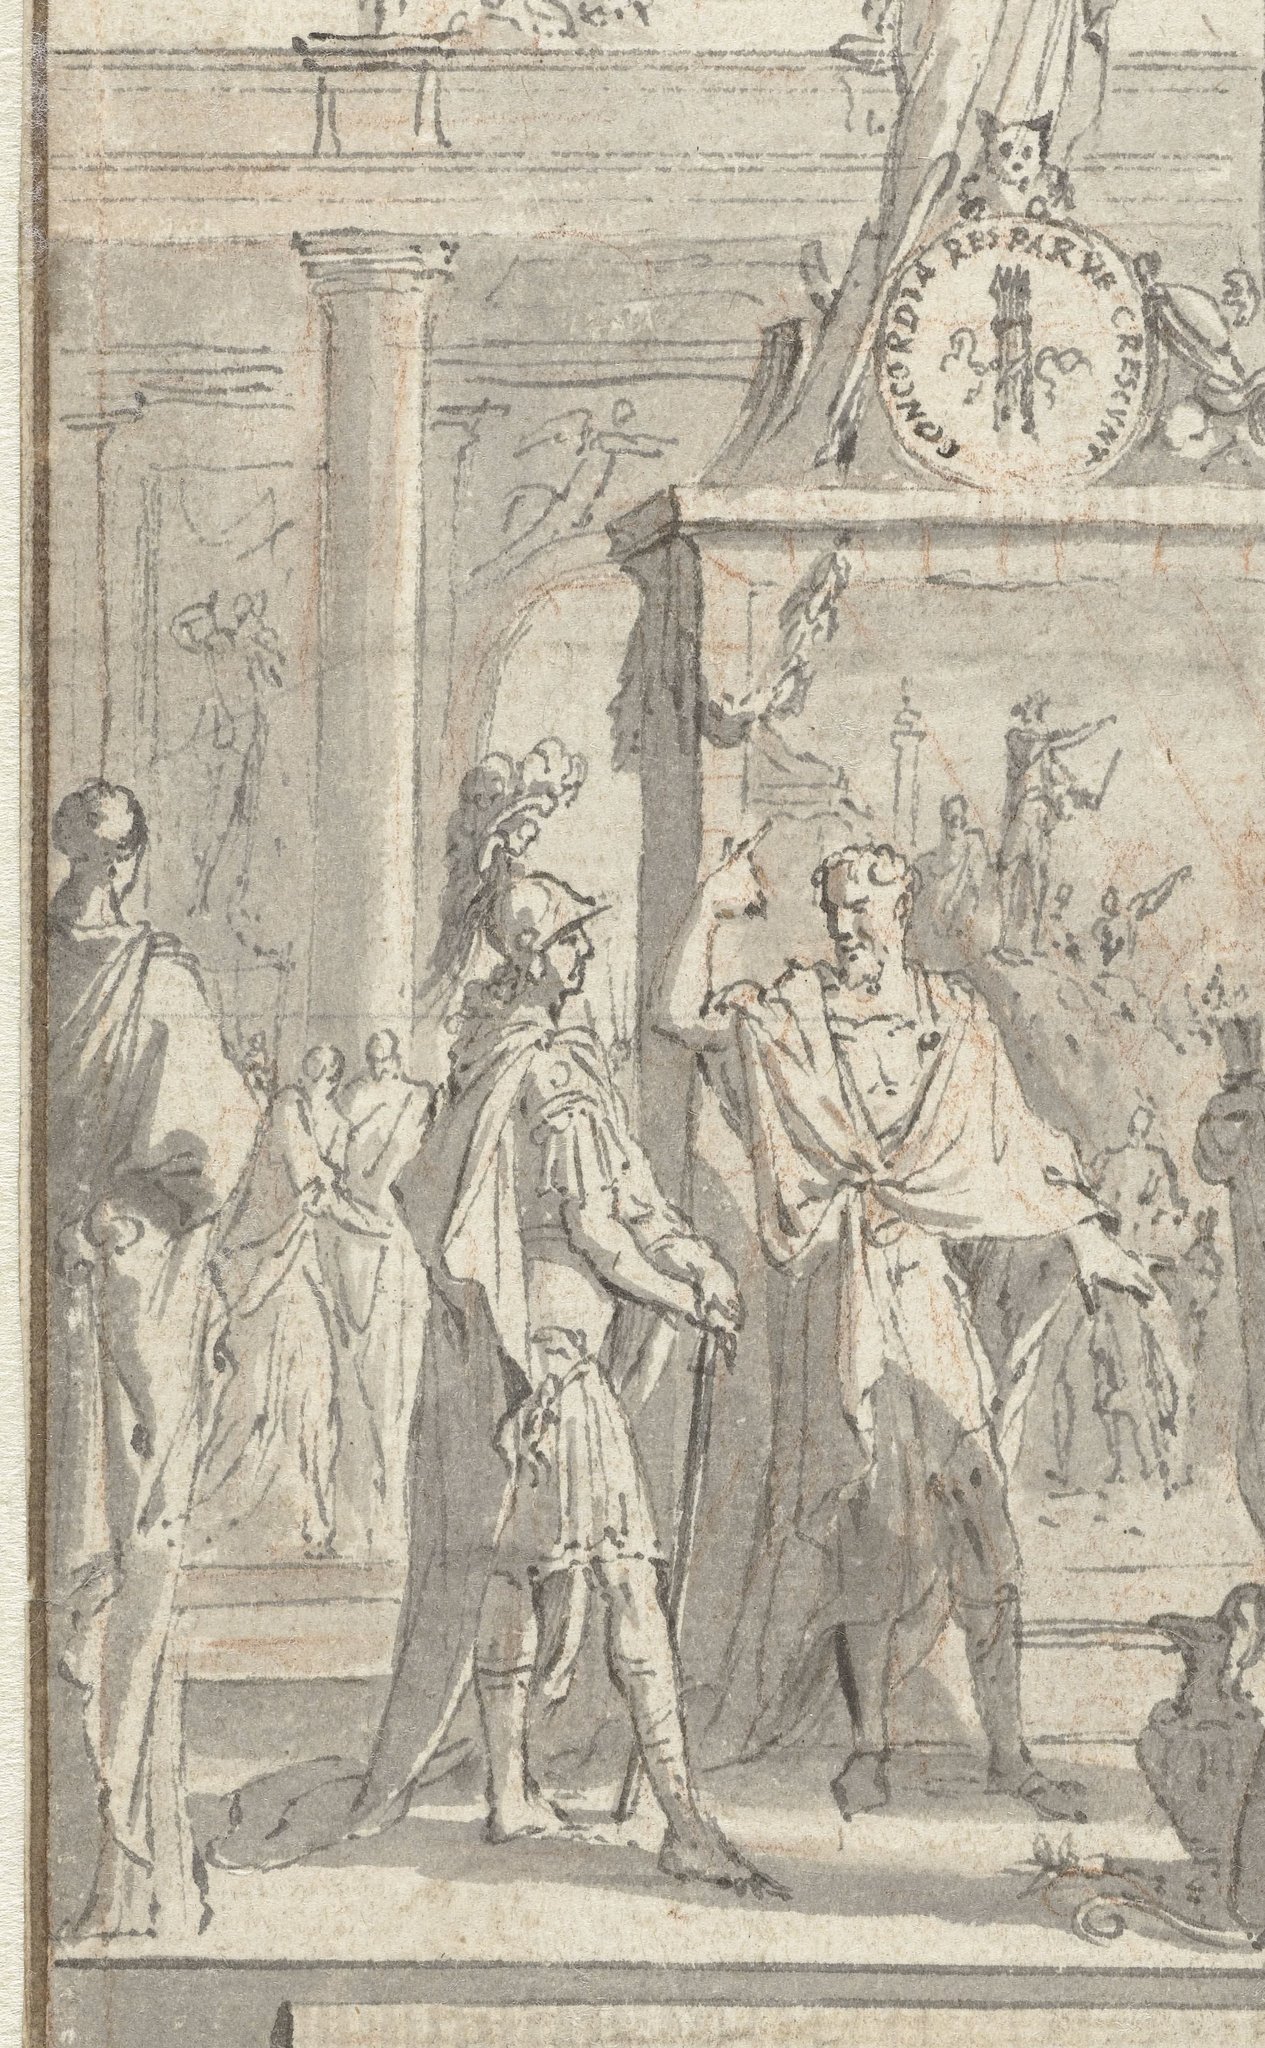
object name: design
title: Personen staand voor een standbeeld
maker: jan goeree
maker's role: draughtsman, print maker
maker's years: 1670-1731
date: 1680-1731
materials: chalk, ink, paper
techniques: brush, pen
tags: agreement, unity; 'concordia', 'concordia insuperabile', 'concordia militare', 'concordia di pace', 'unione civile' (ripa), roman personifications of abstract concepts, piece of sculpture, reproduction of a piece of sculpture, male persons from classical history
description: Scène uit de Romeinse geschiedenis: enkele personen staande voor een standbeeld. Ontwerp voor een boekillustratie.